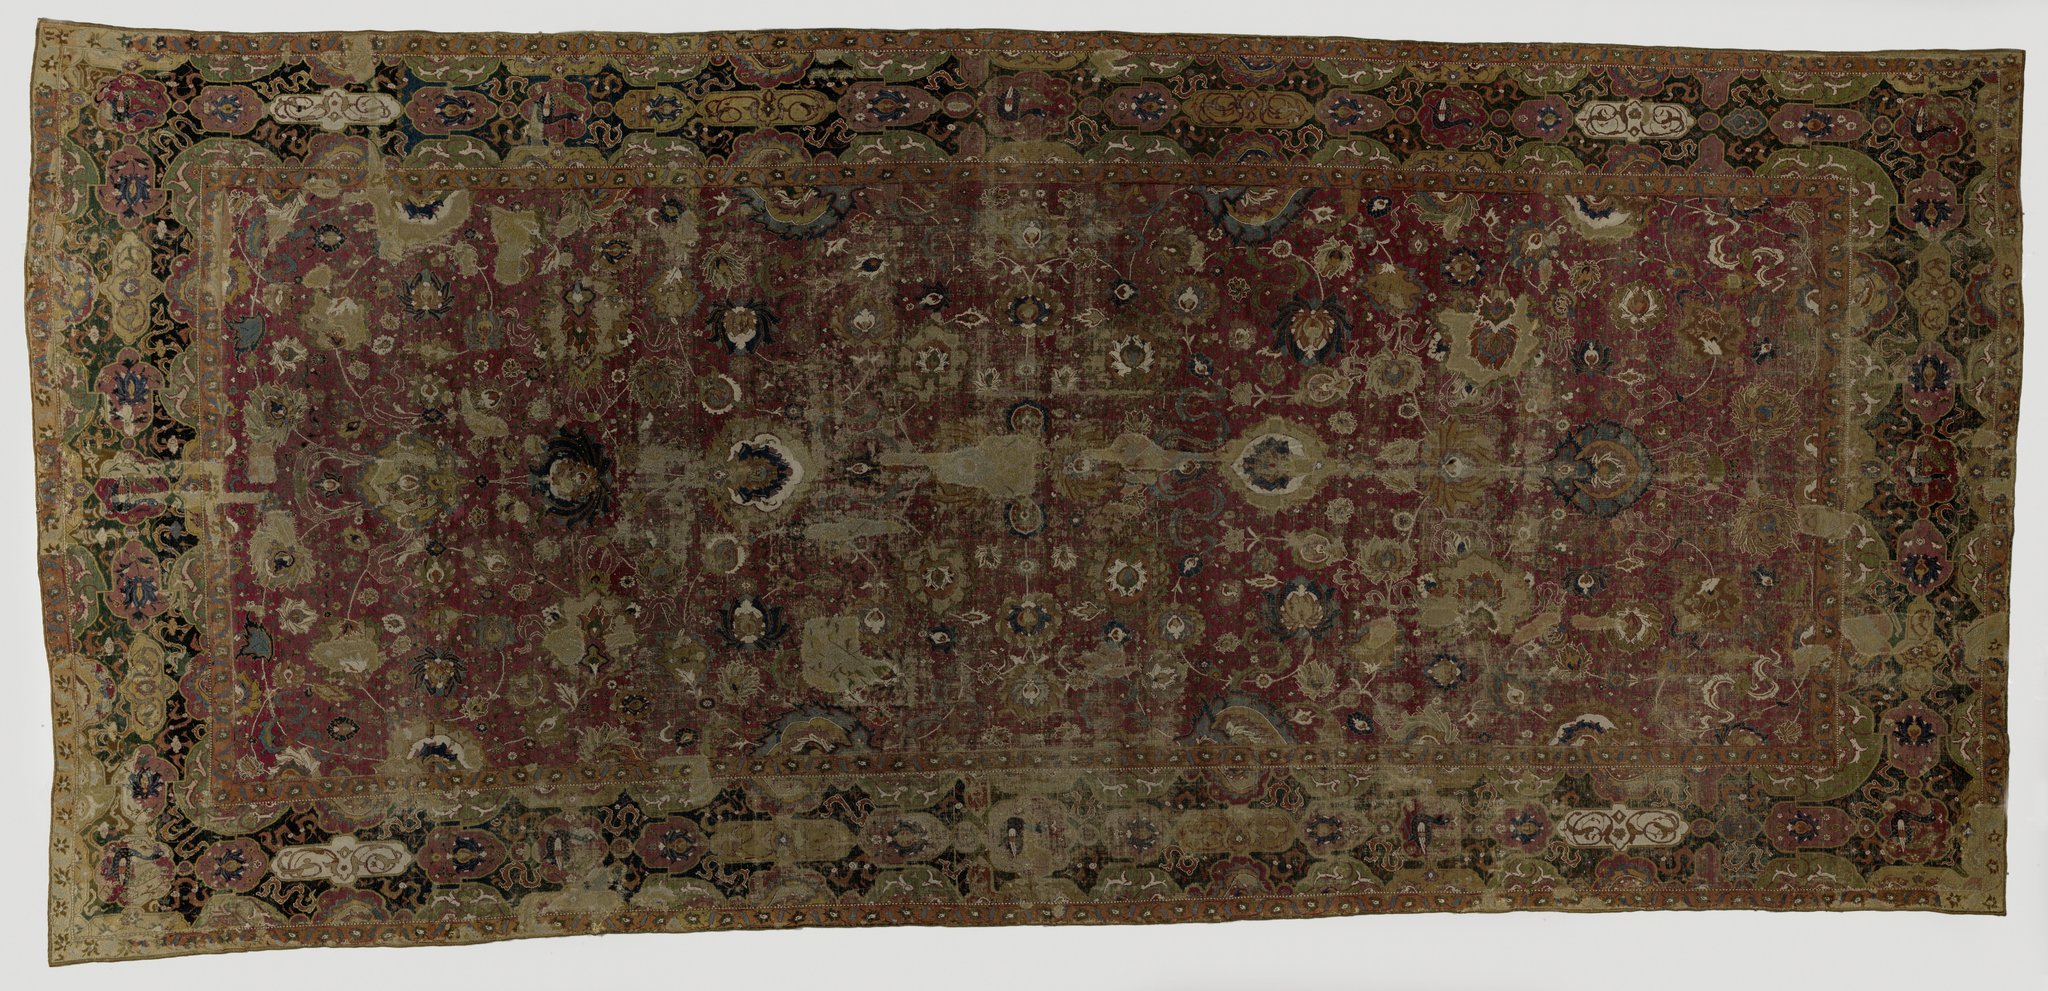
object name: oriental rug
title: Oosters tapijt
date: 1500-1700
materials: wool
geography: herat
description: Oosters tapijt, arabesken- en bloementapijt, van geknoopte wol (?) met Herati-patroon; ranken, lotussen, palmetten in verschillende kleuren tegen een karmijnrood fond.